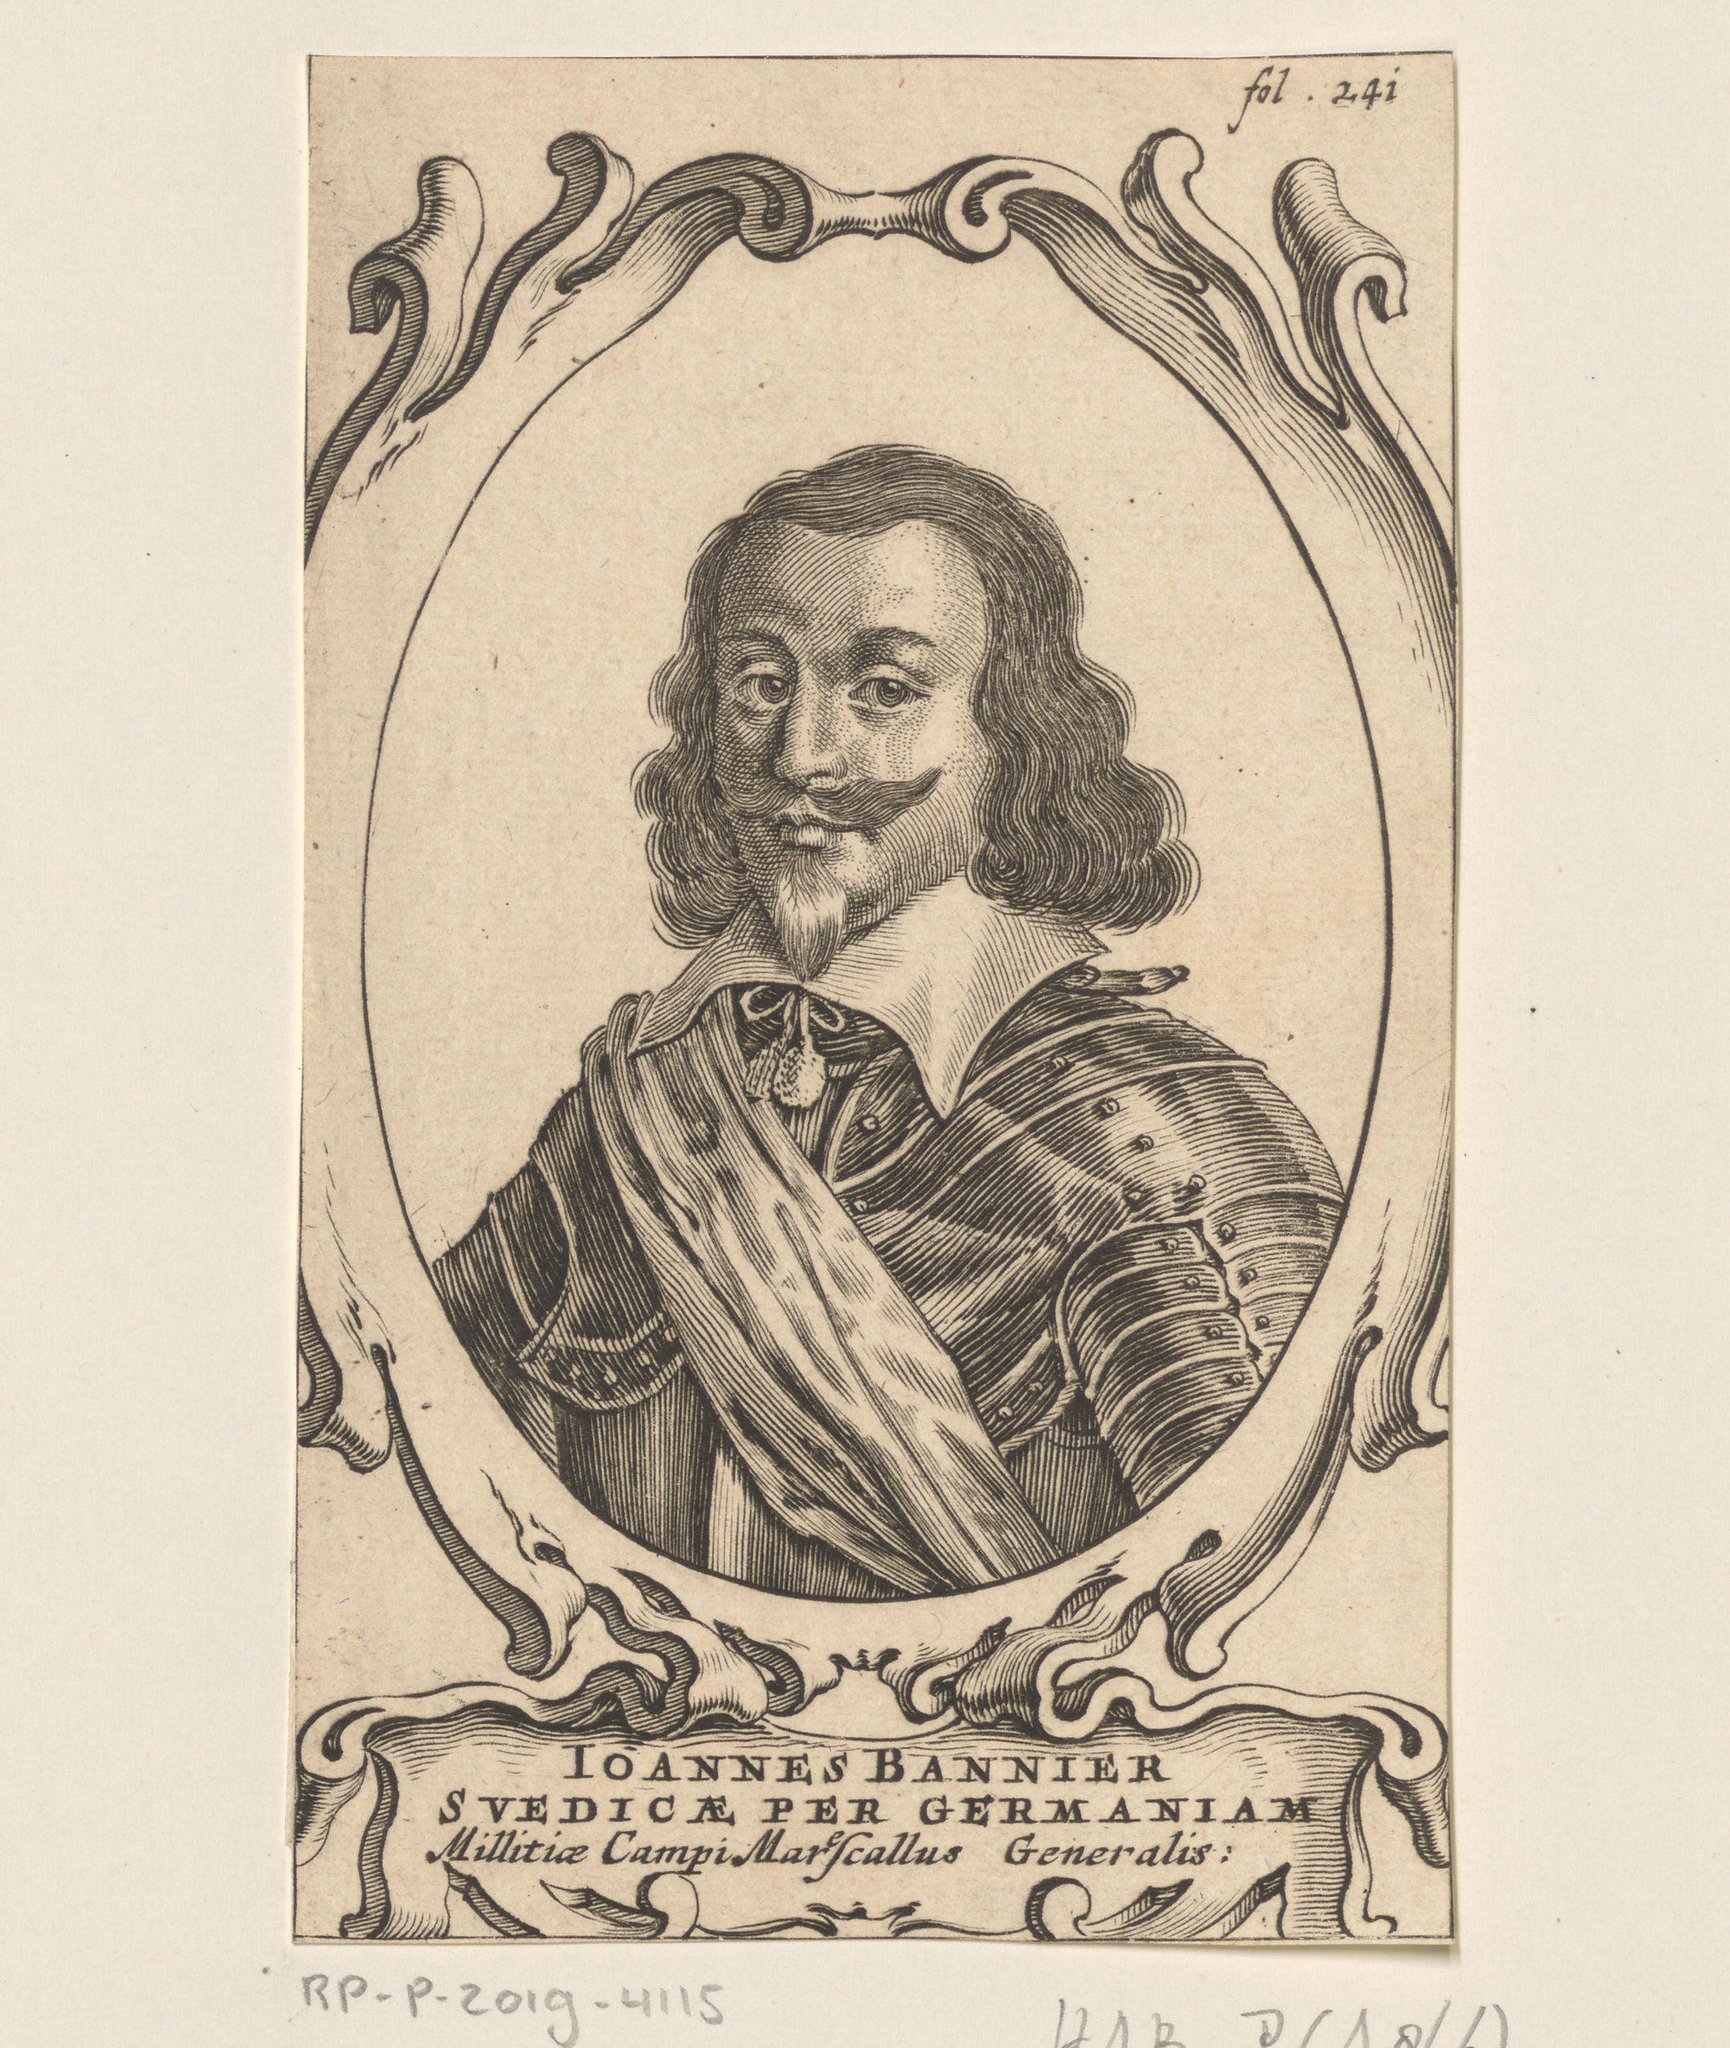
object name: book illustration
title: Portret van Johan Banér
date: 1656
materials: paper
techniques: engraving, etching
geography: rotterdam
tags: politician, armour, historical persons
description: Prent uit: Brachelius, Johannes Adolphus. Historia nostri temporis, dat is: geschiedenis onses tijdts, (...). Rotterdam: Andries van Hoogenhuyse, 1656. Prent ook gebruikt in latere edities van dit werk.